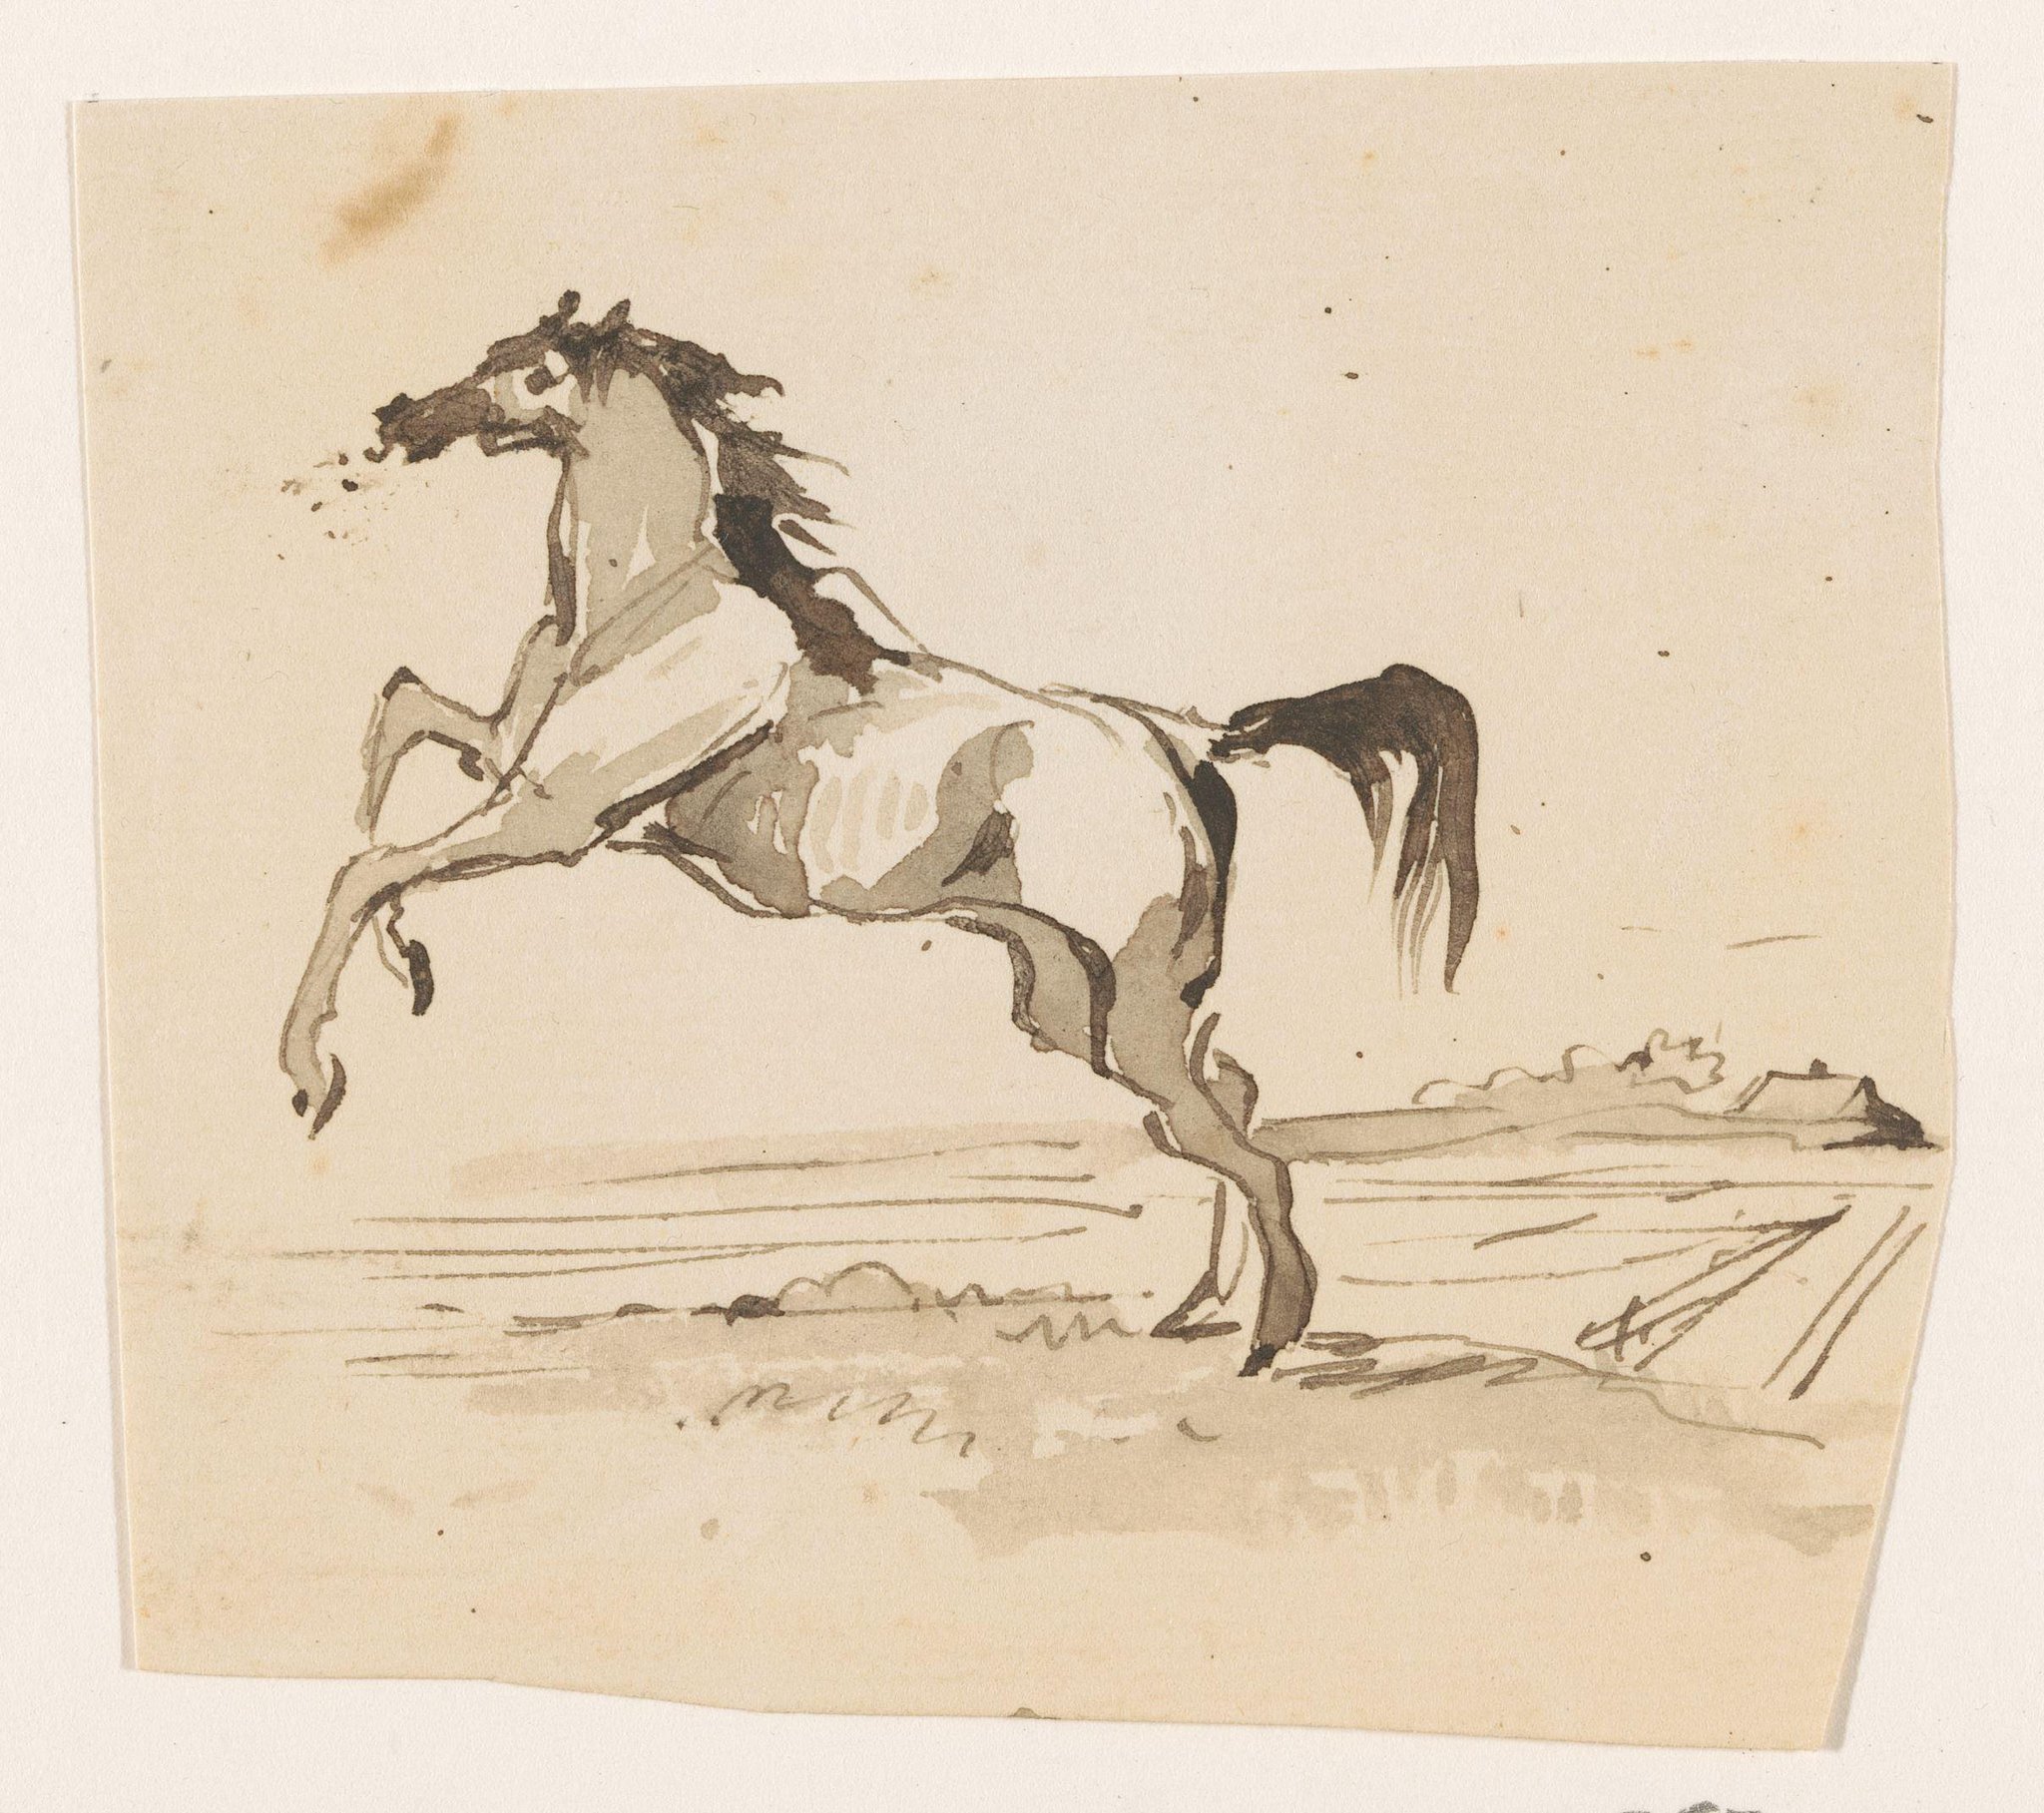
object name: drawing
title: Springend paard, in het veld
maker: johannes tavenraat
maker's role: draughtsman, painter, print maker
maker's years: 1809-1881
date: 1840-1880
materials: ink, paper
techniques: brush, pen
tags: horse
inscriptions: collector's mark: Lugt 2228, signature: ‘Tavenraat’